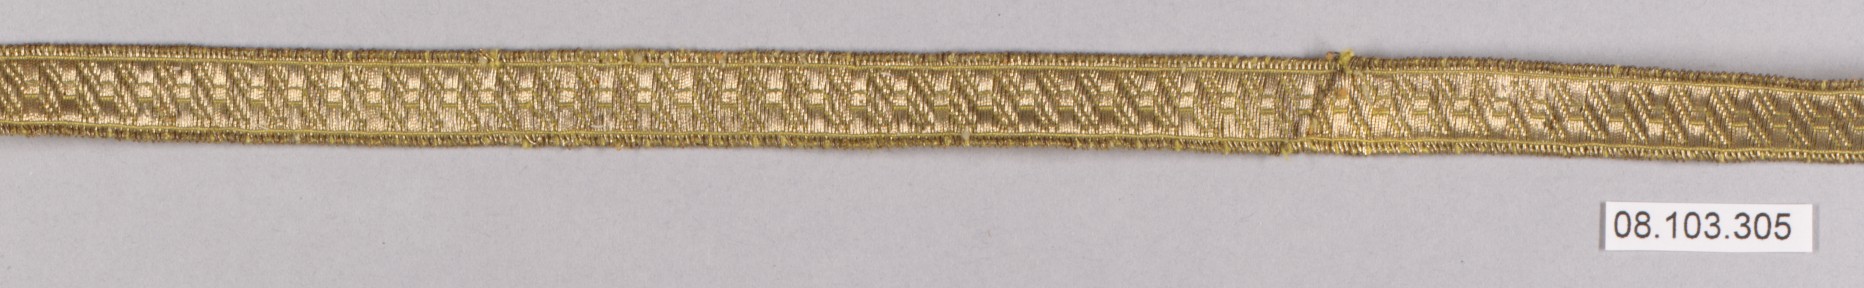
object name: galloon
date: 1601-1800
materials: silk